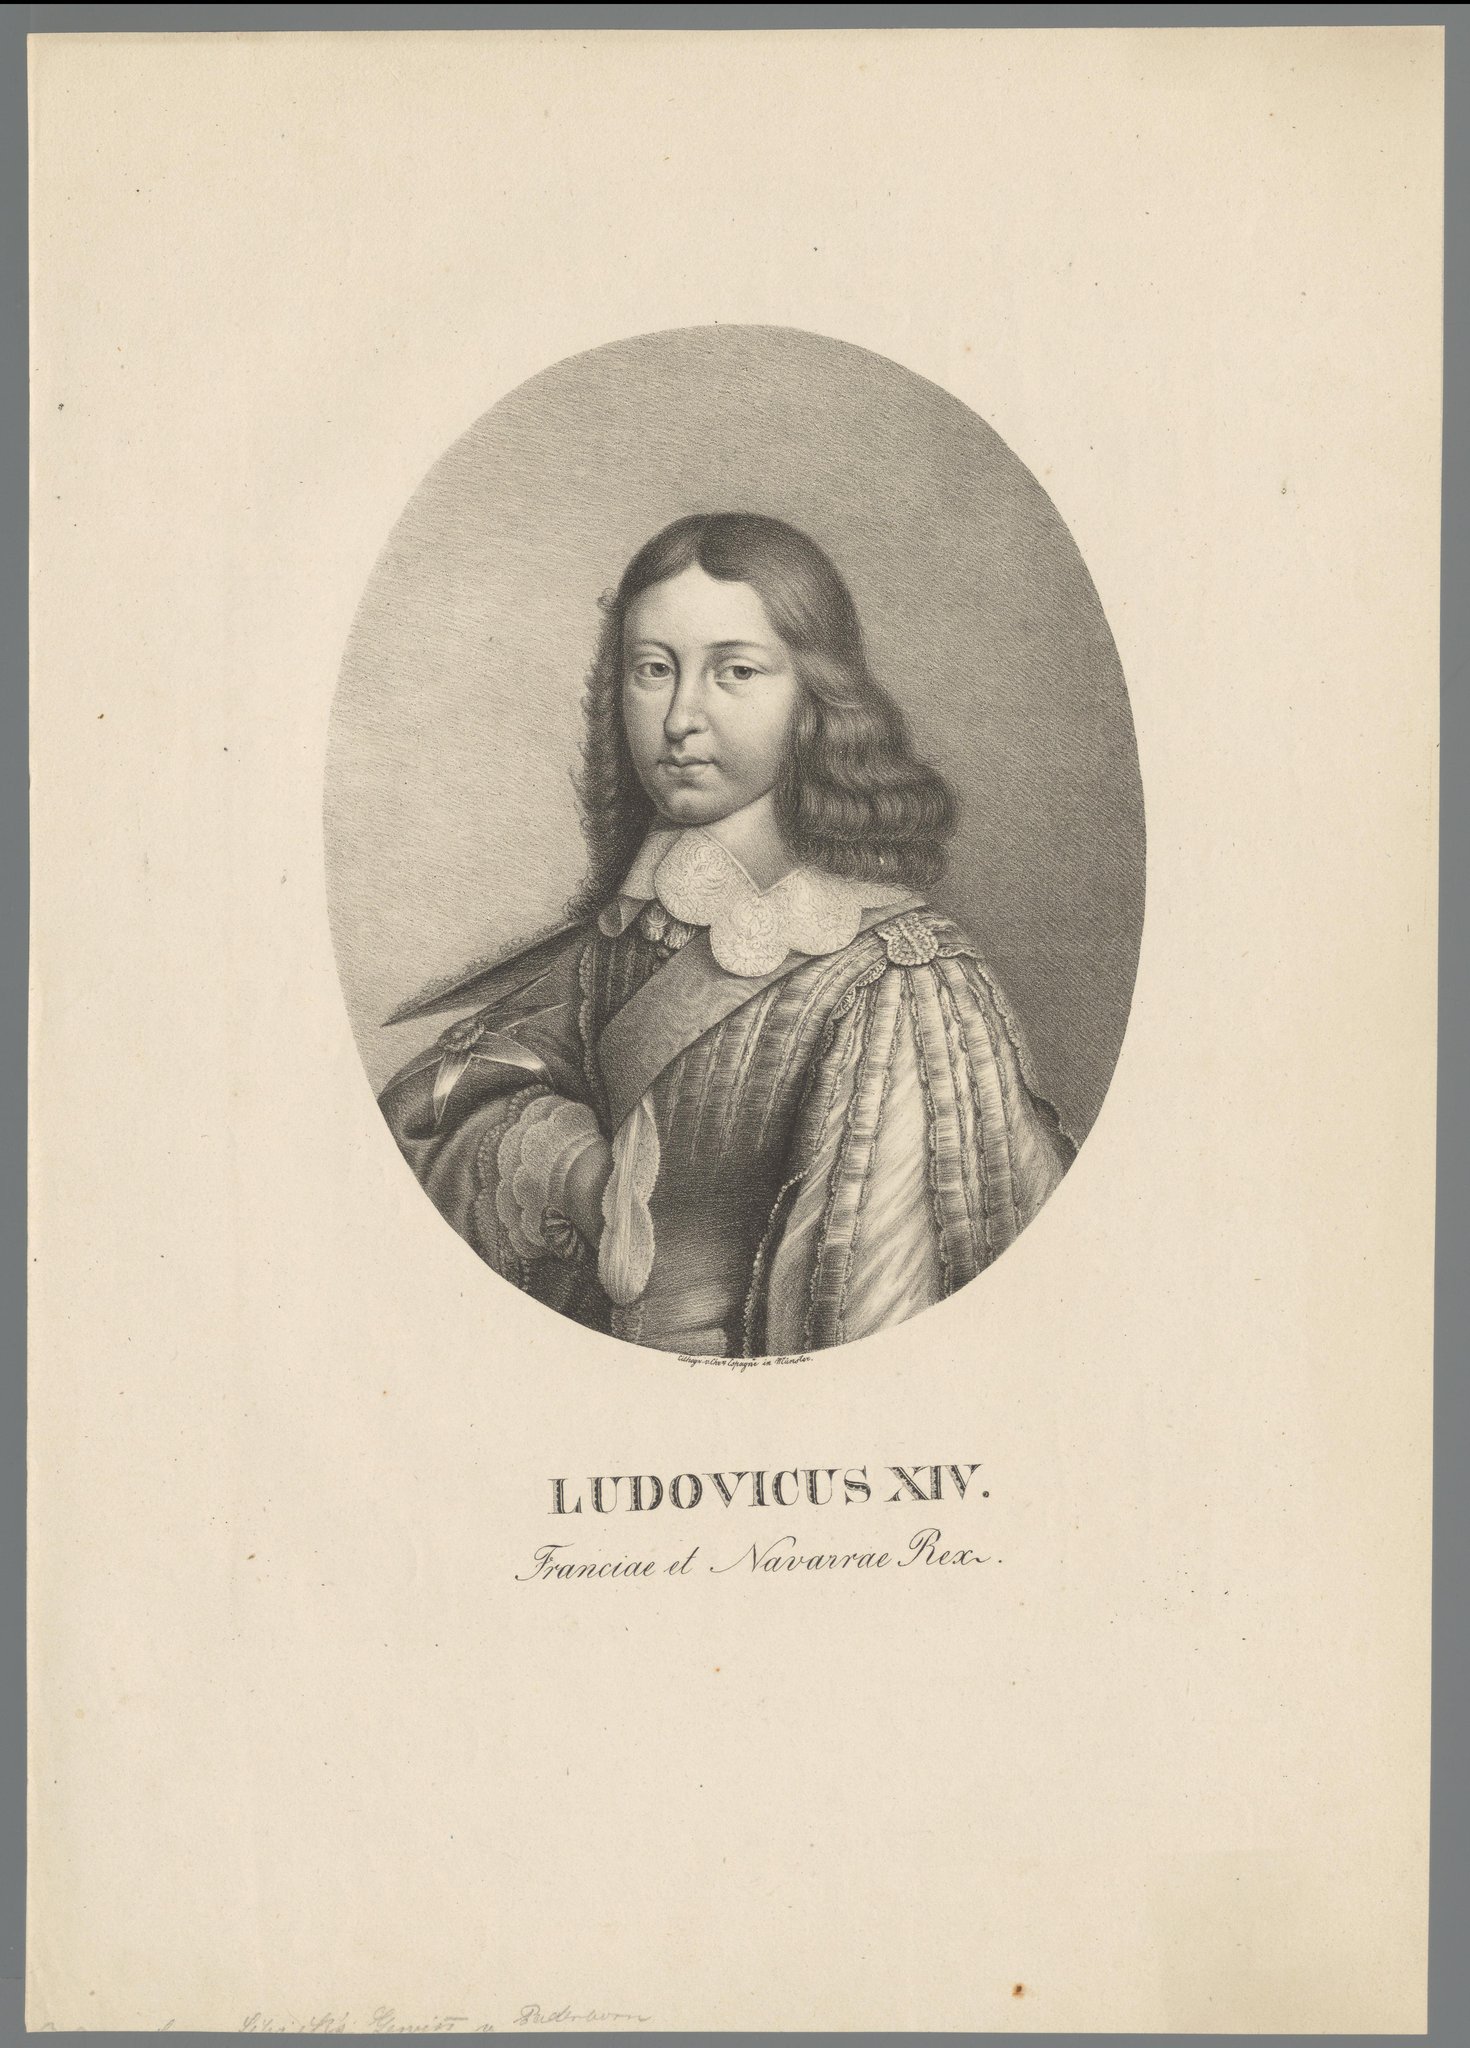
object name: print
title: Ludovicus XIV, Franciae et Navarrae rex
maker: christian espagne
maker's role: print maker, printer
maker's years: 1794-1838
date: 1824-1827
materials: paper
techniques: lithograph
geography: munster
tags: lodewijk xiv (koning van frankrijk), historical persons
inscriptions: collector's mark: Lugt 2228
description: Prent uit: Bildnisse der beim westfälischen Friedensschluß zu Münster und Osnabrück versammelt gewesenen Gesandten. Münster: Christian Espagne, [1824-1827]. Deze publicatie bevat een onbekend aantal lithografieën, die in afleveringen verschenen als illustratie bij de tekst.